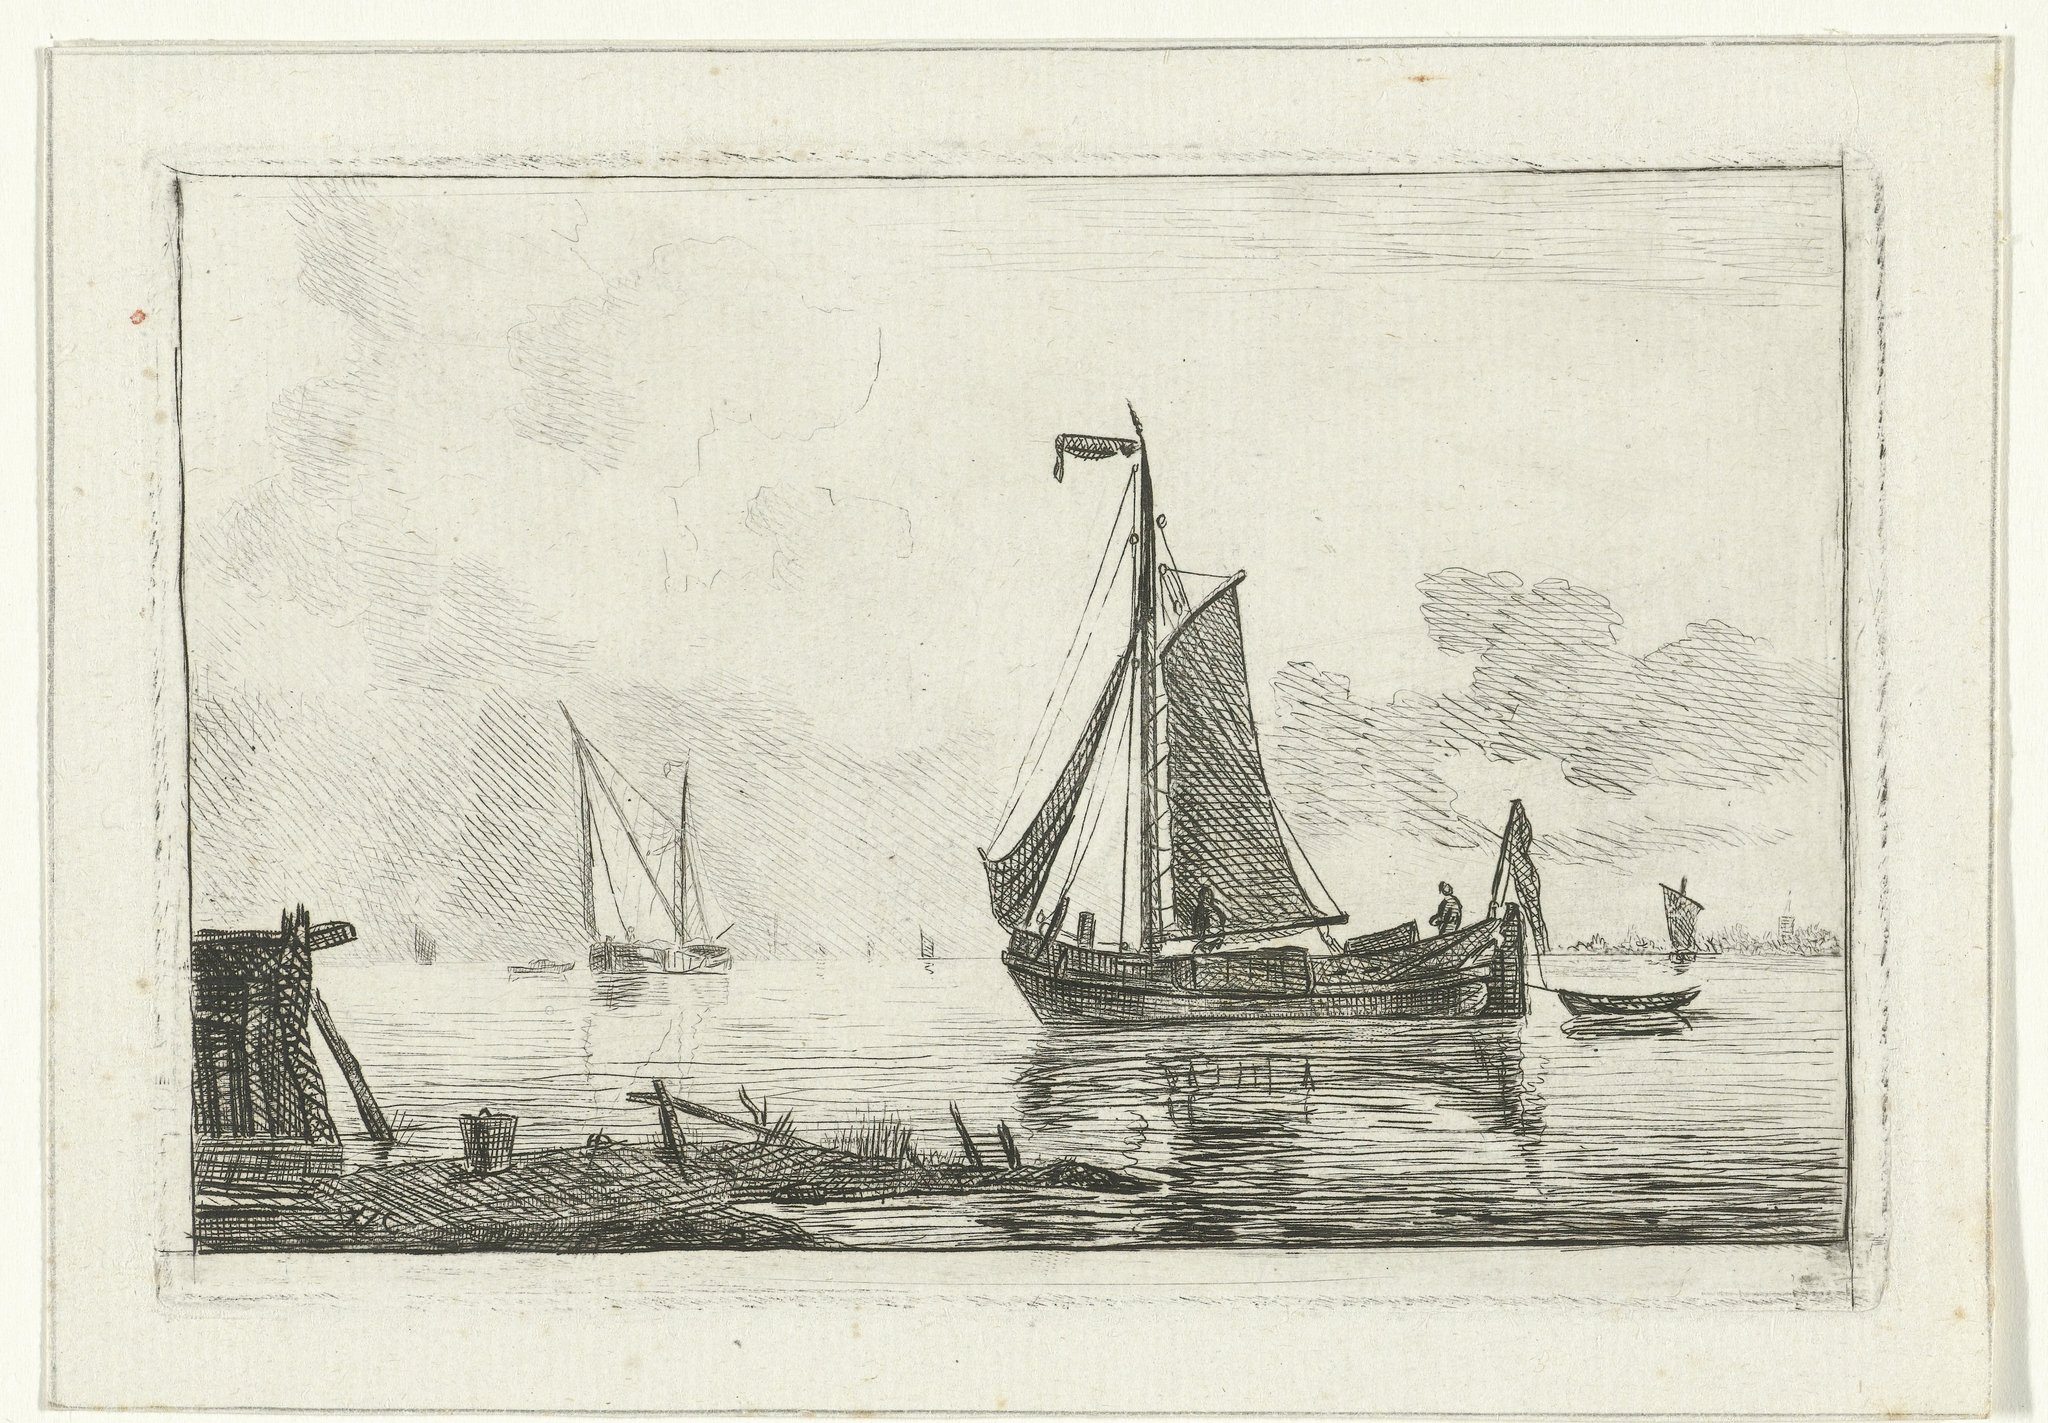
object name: print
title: Riviergezicht met zeilschip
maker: willem gruyter jr.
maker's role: draughtsman, print maker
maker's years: 1817-1880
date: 1832-1880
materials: paper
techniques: engraving, etching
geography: amsterdam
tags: sailing-ship, sailing-boat (+ view ~ vehicle, ship, etc.)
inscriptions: collector's mark: Lugt 2165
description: Riviergezicht met zeilschip op de flank gezien. Links een pier.